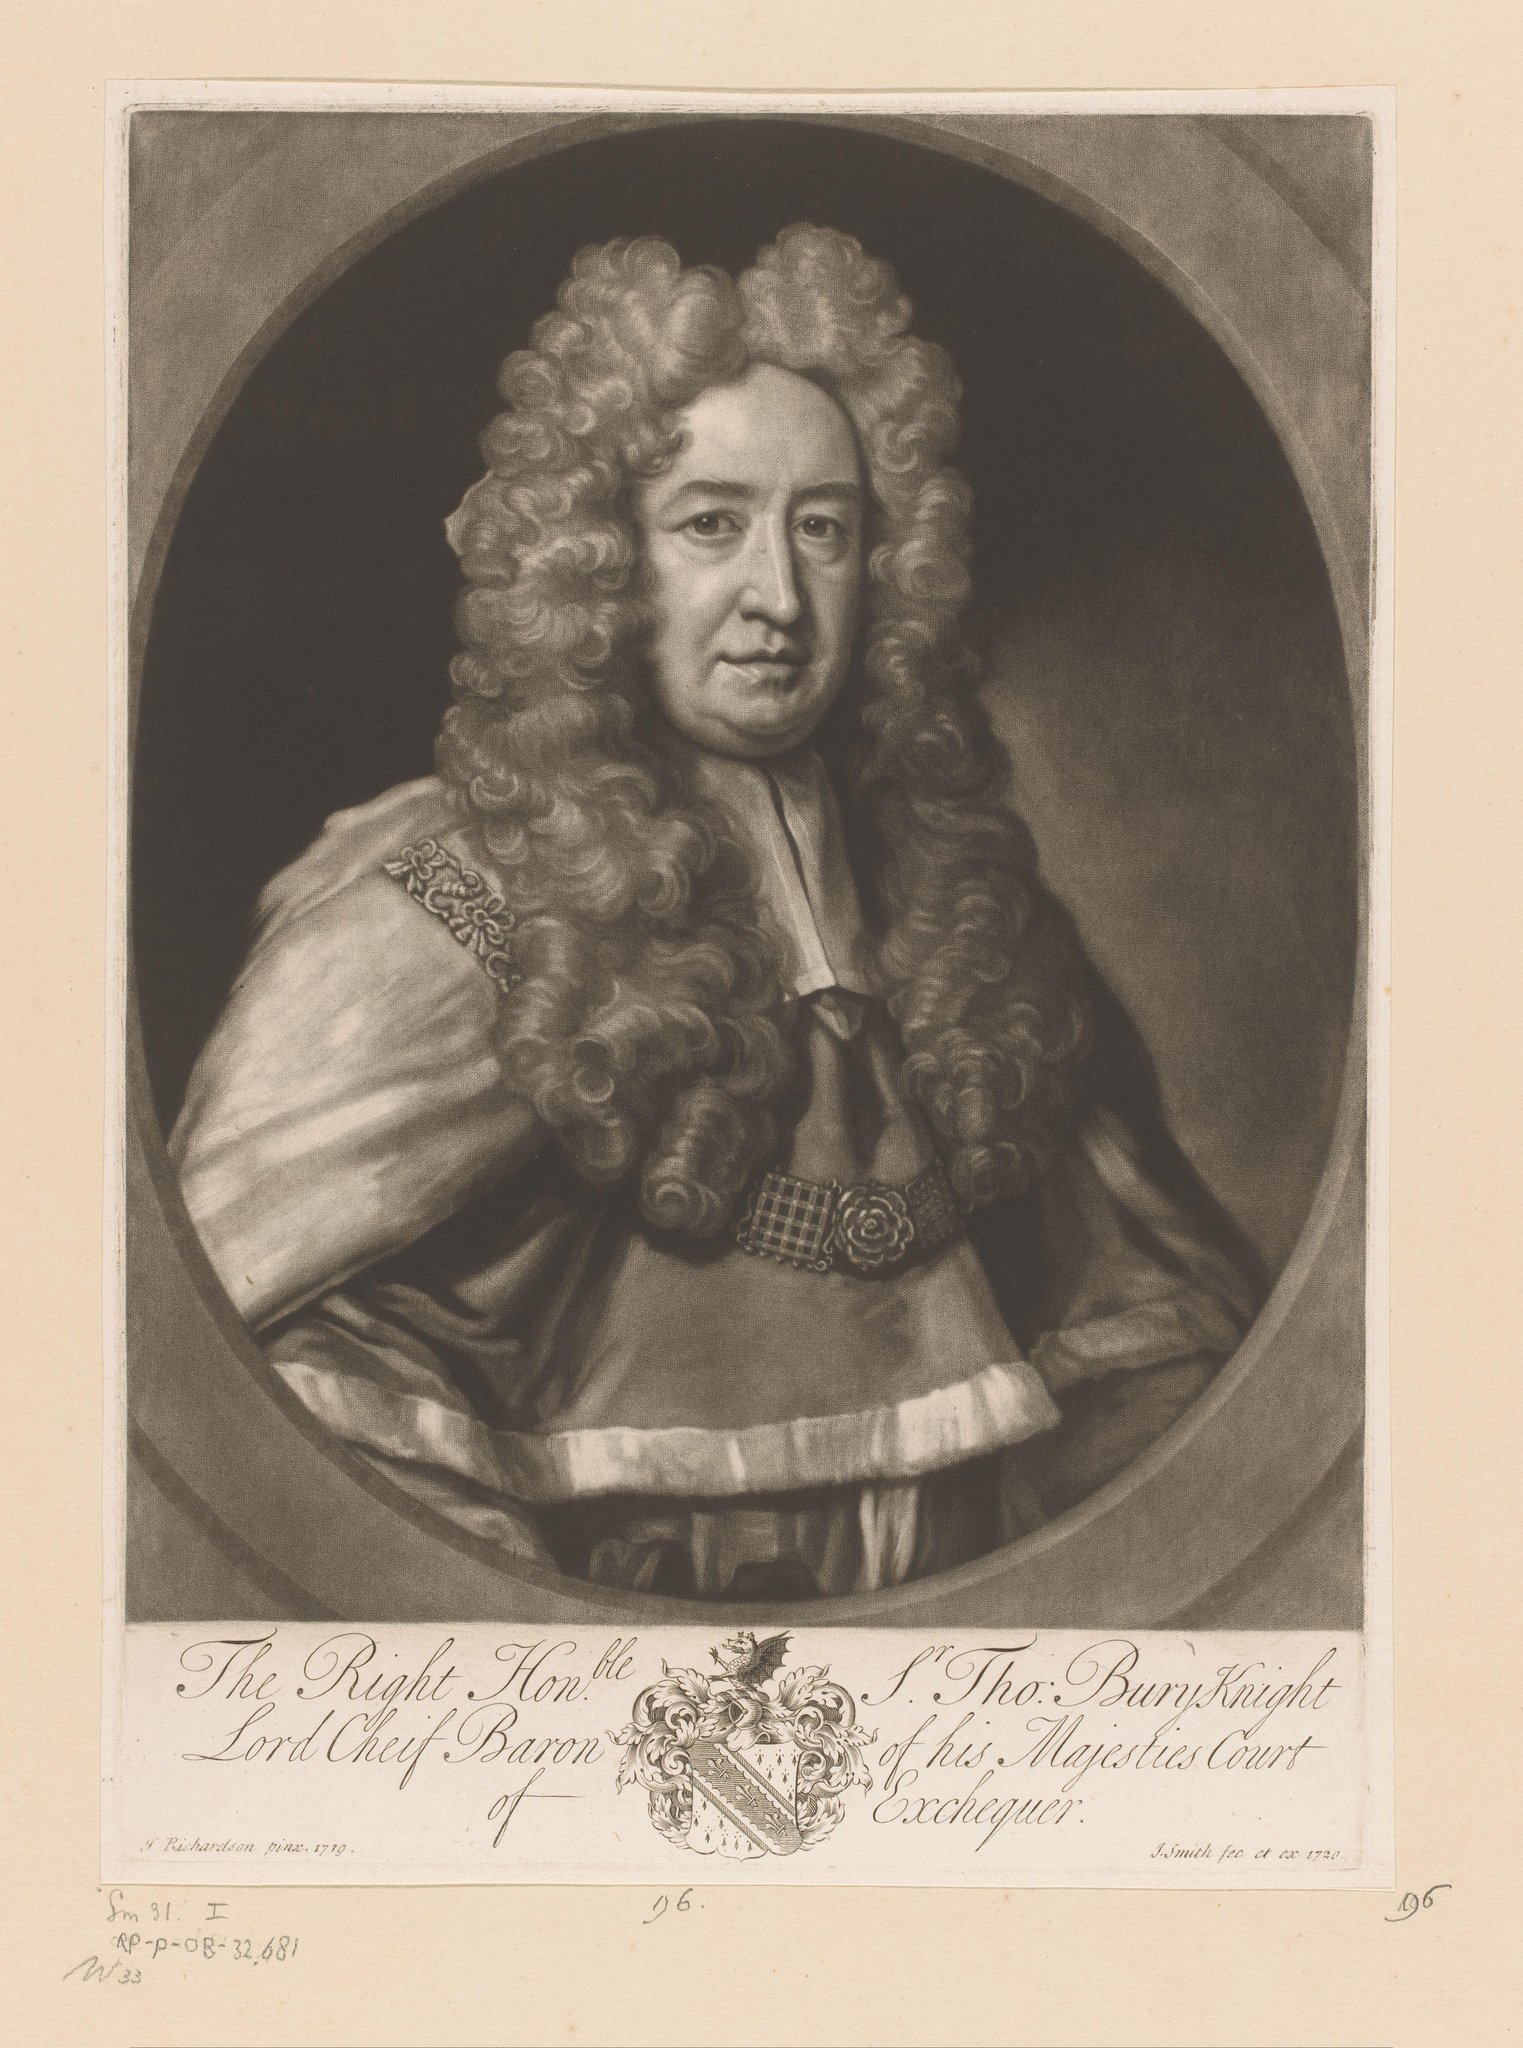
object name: print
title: Portret van Thomas Bury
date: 1719-1720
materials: paper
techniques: etching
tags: jury, historical persons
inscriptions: collector's mark: Lugt 240